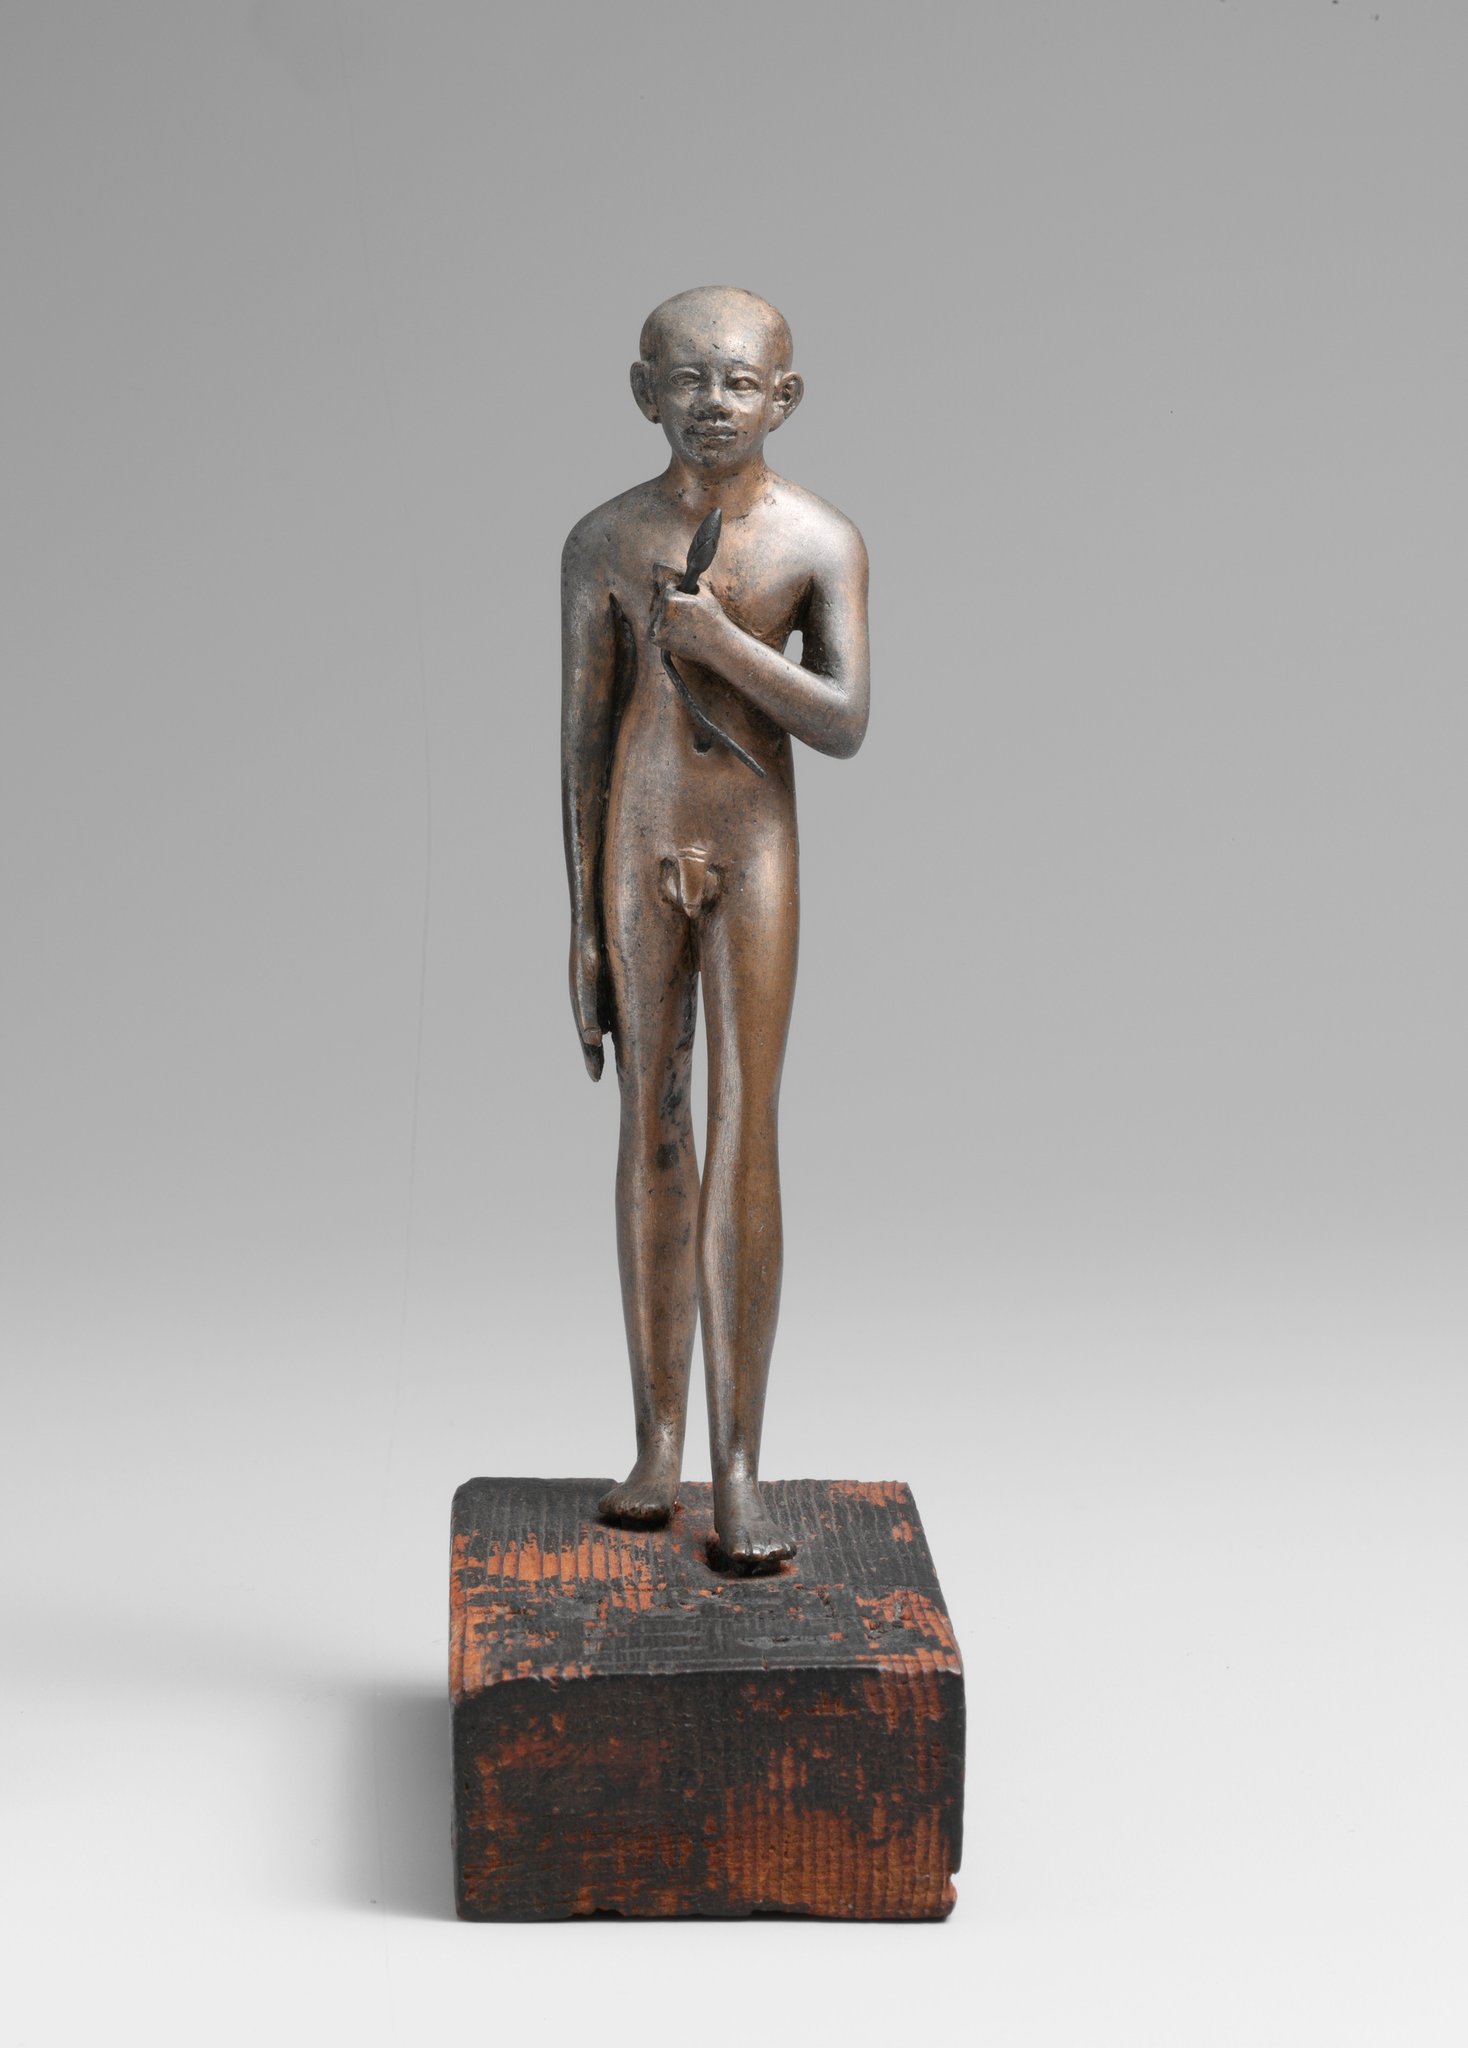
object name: statuette, standing boy, nude, amenemhab, child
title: Statuette of the Child Amenemhab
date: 1550-1479 BCE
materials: bronze, silver, wood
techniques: inlay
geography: egypt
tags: boys,male nudes,lotuses